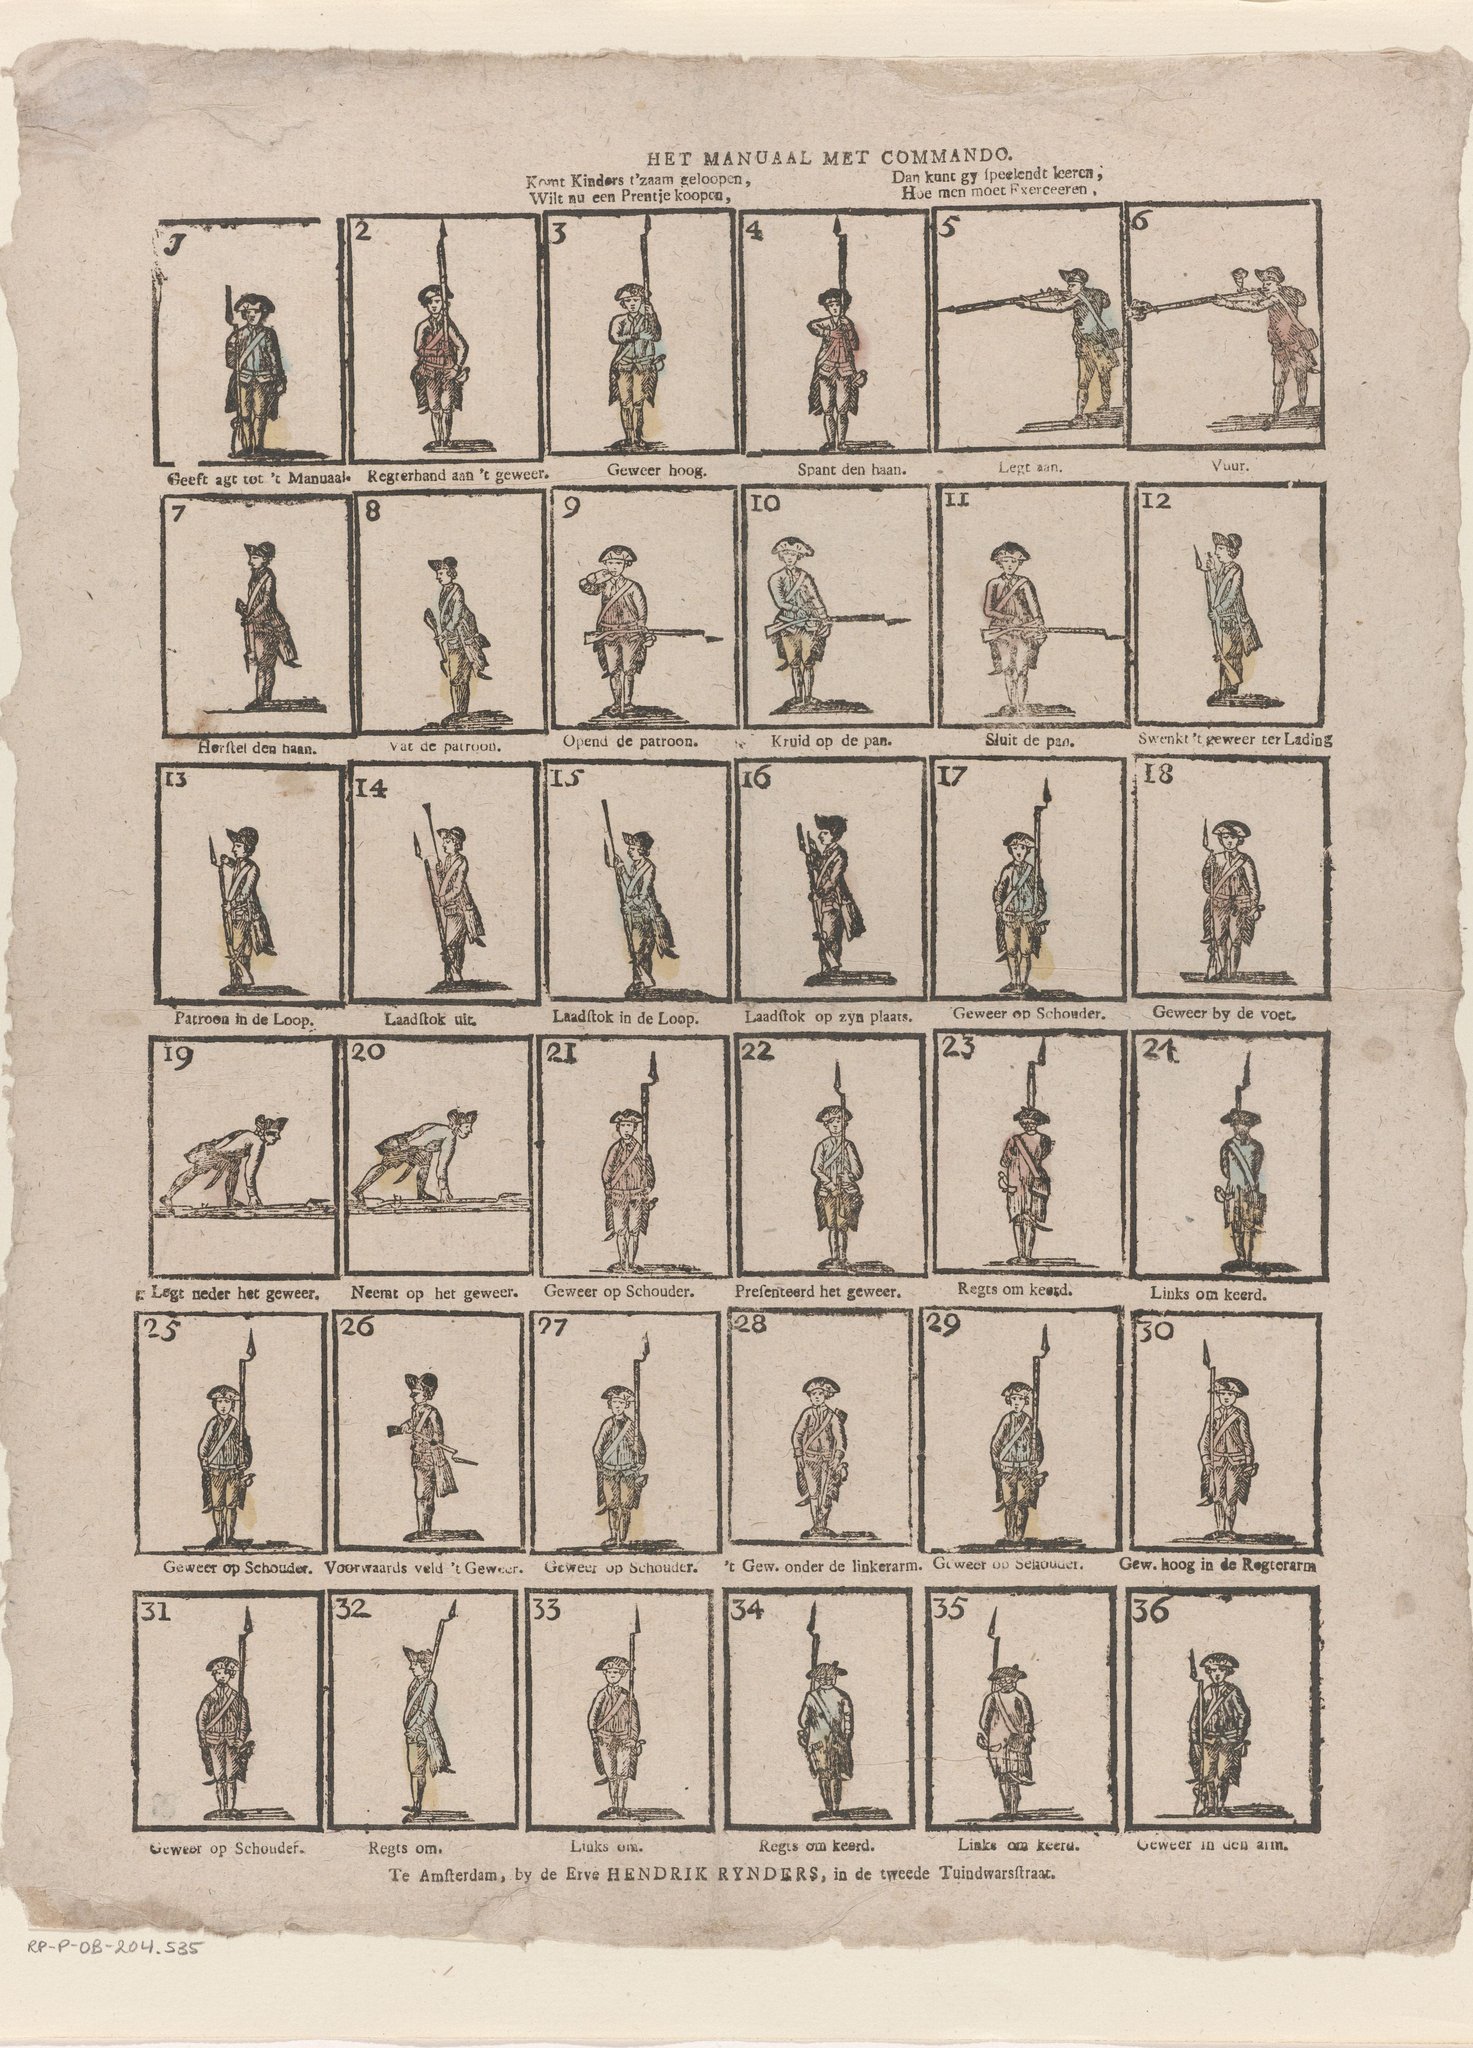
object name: print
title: Het manuaal met commando / Komt kinders t'zaam geloopen [(...)]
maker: Anonymous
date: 1831-1854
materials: paper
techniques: colour, letterpress printing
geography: amsterdam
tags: drill ~ military training, weapons, the soldier; the soldier's life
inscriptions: collector's mark: Lugt 2760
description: Blad met 36 genummerde voorstellingen van soldaten met een geweer. Onder elke afbeelding een onderschrift.